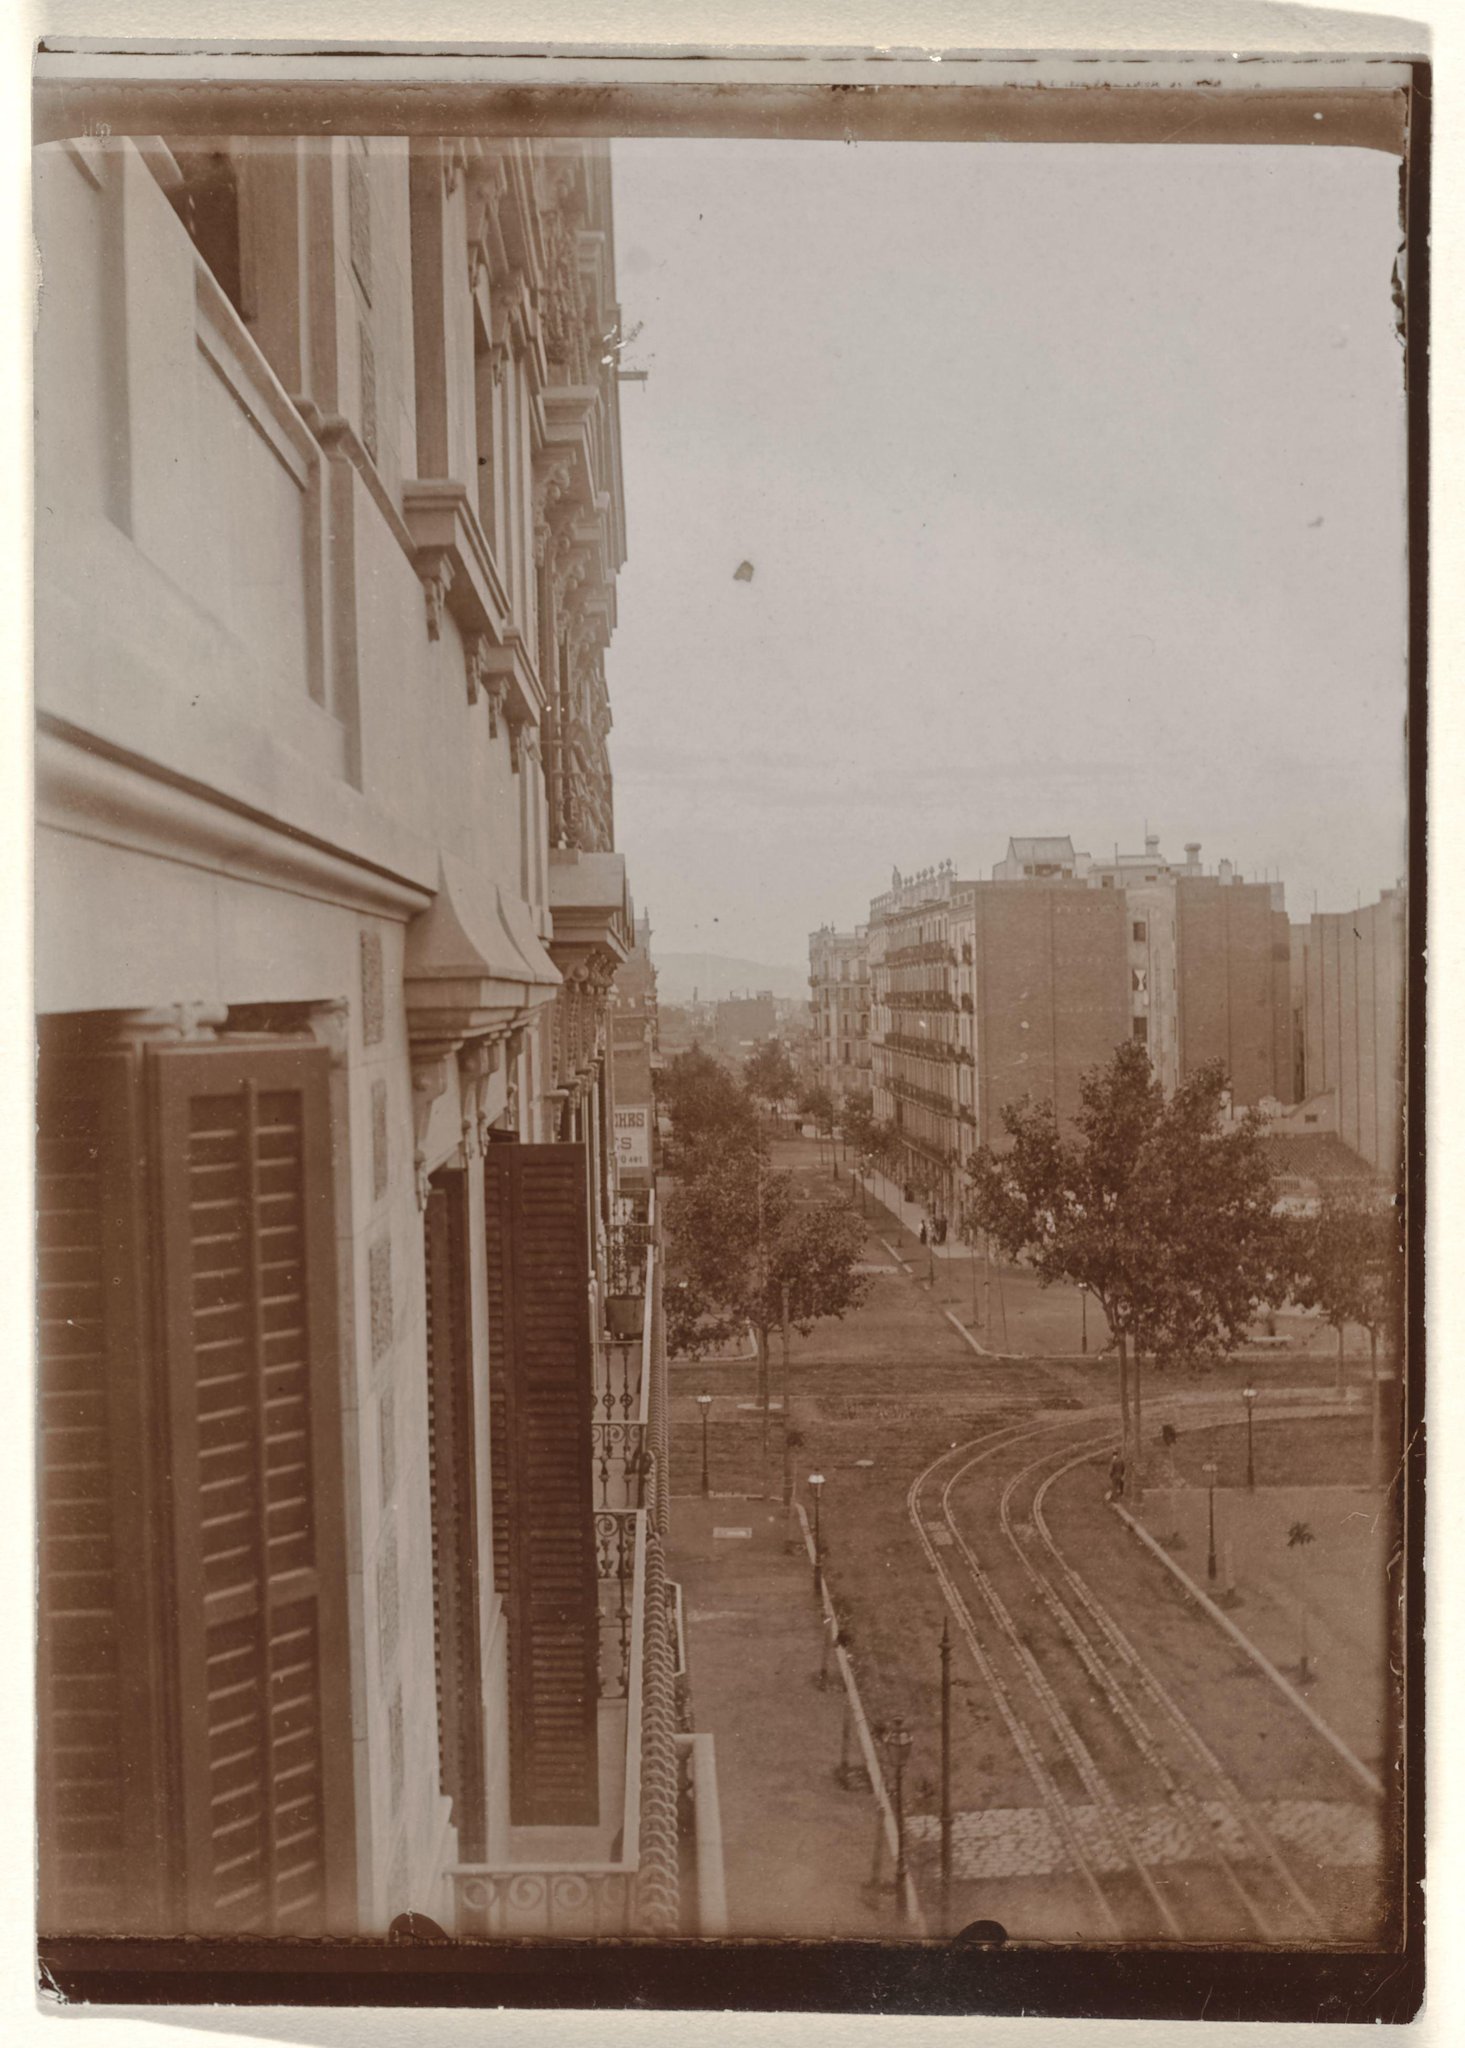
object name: photograph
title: Gezicht vanaf een balkon op een straat in een onbekende stad, 1905-1922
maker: Anonymous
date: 1905-1922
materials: photographic support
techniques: gelatin silver print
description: Zicht vanaf een balkon op een straat in een onbekende stad.